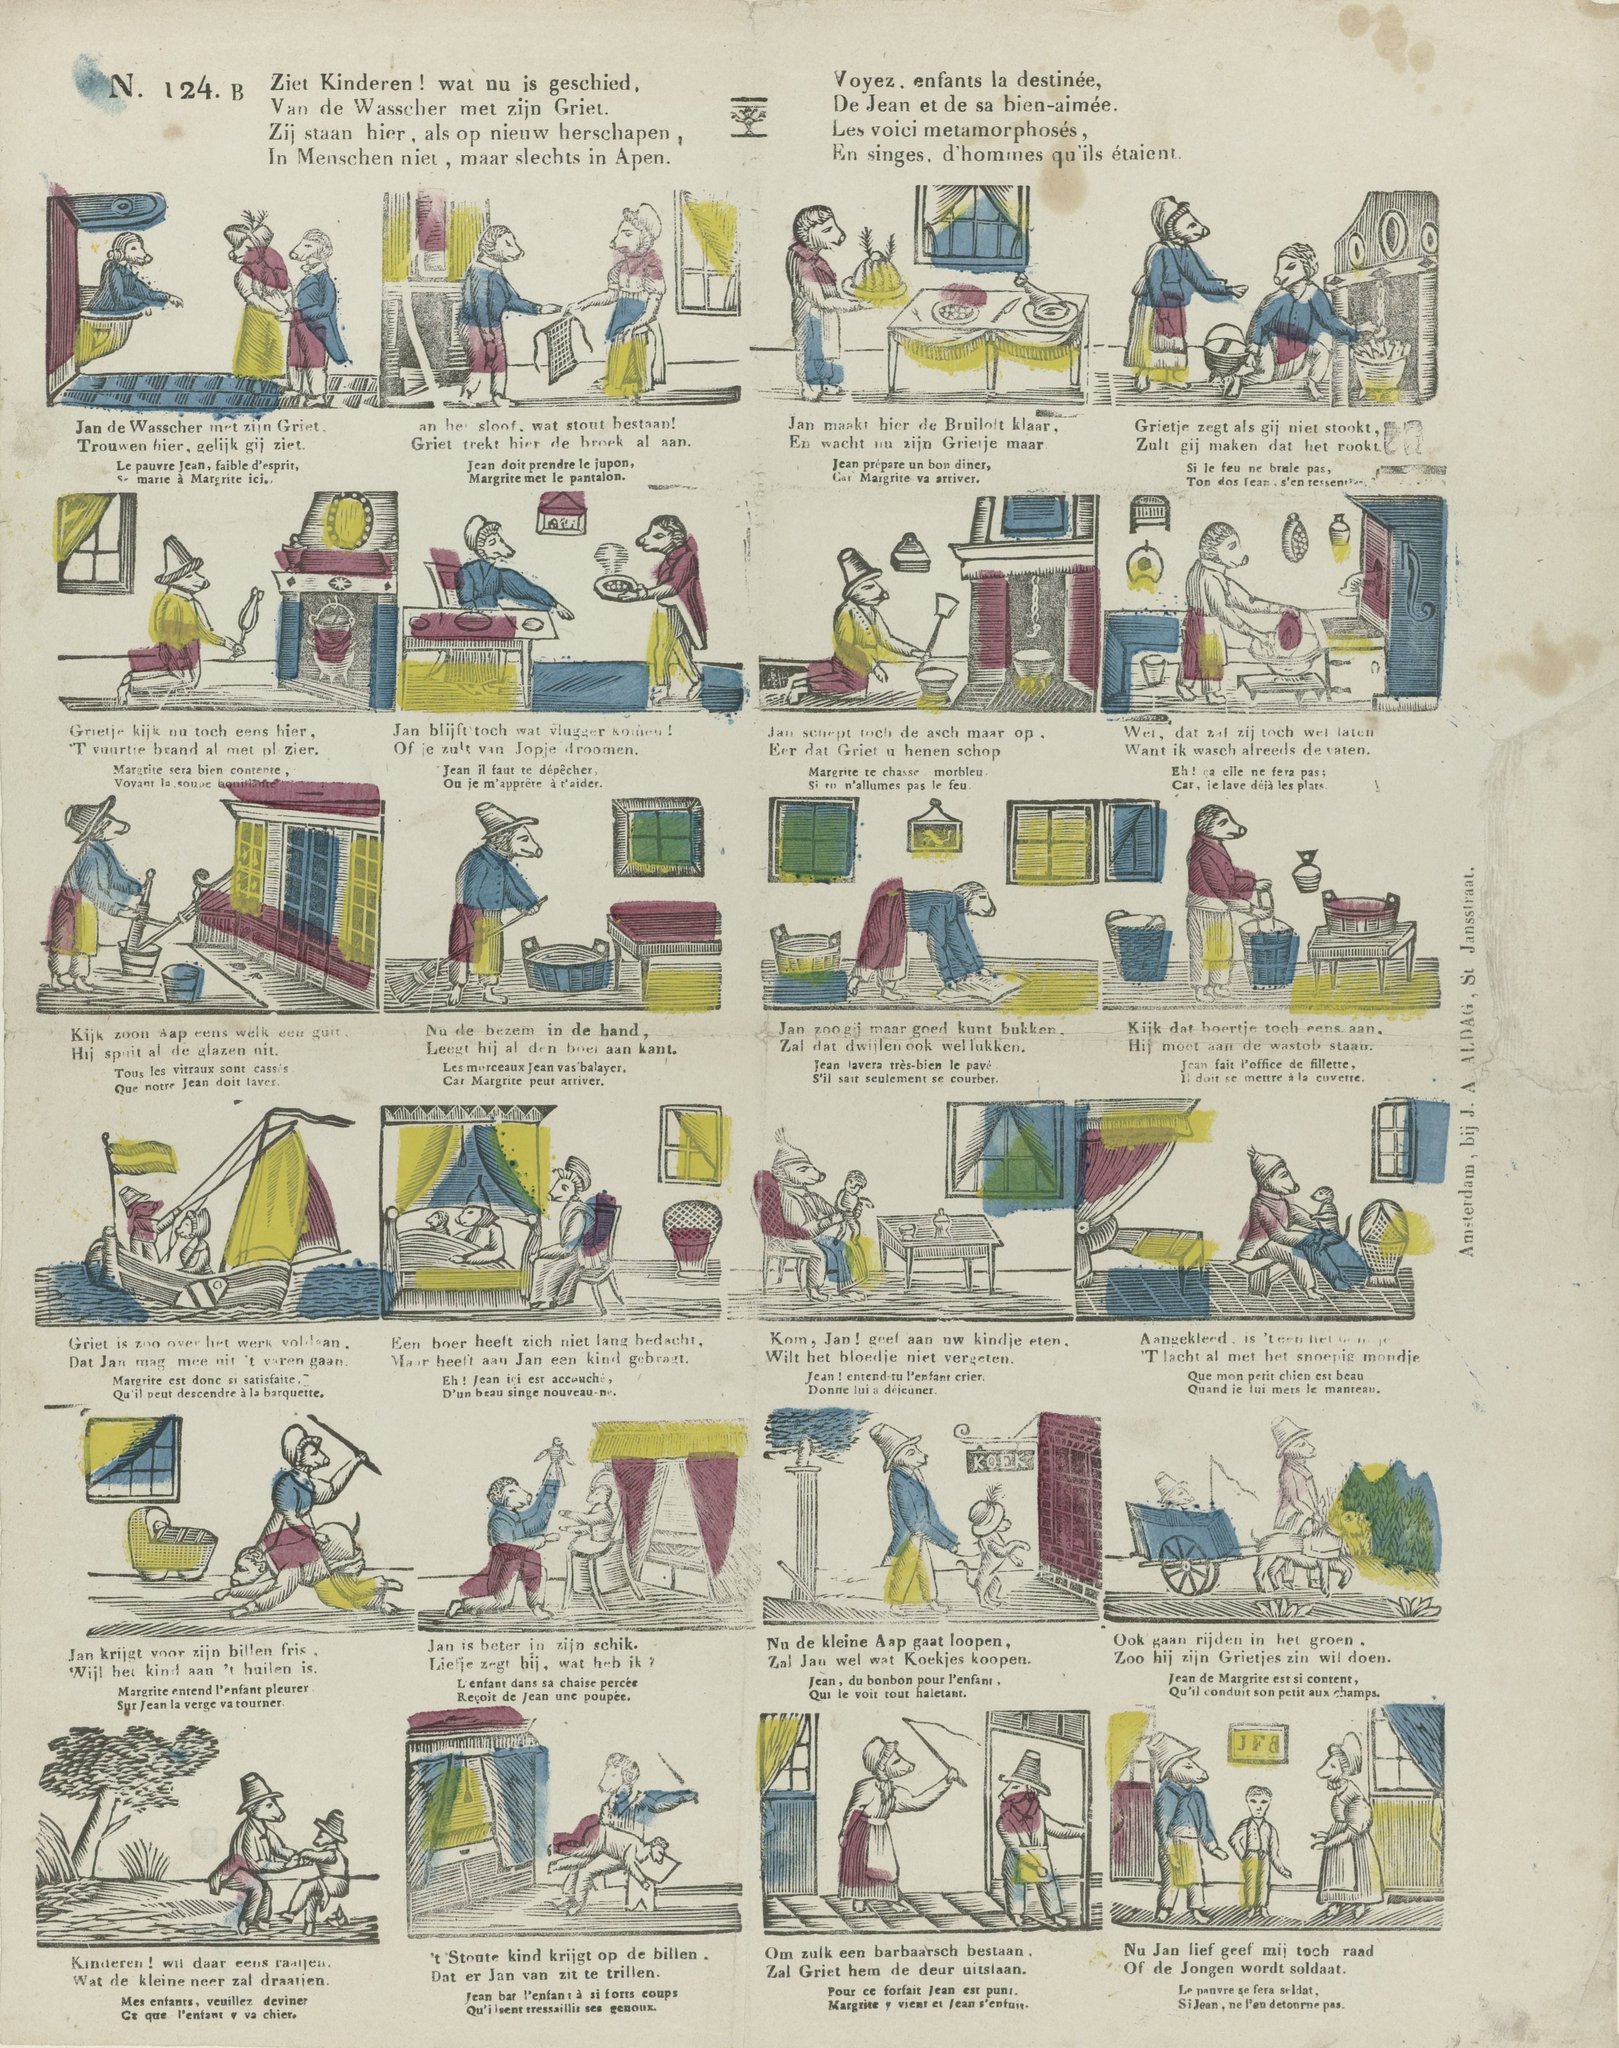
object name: print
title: Ziet kinderen! wat nu is geschied, / Van de Wasscher met zijn Griet [(...)]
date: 1851-1880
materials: paper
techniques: colour, letterpress printing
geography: amsterdam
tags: hen-pecked husband, 'betty', 'molly' (man who engages in women's work), monkeys, apes, animals acting as human beings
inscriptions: collector's mark: Lugt 2760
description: Blad met 24 voorstellingen uit het leven van Jan de Wasser, een man die van zijn vrouw Griet, die de broek aan heeft, al het huishoudelijk werk moet doen. Uitgebeeld met apen in plaats van mensen. Onder elke voorstelling een tweeregelig vers in het Nederlands en in het Frans. Genummerd linksboven: N. 124.B.